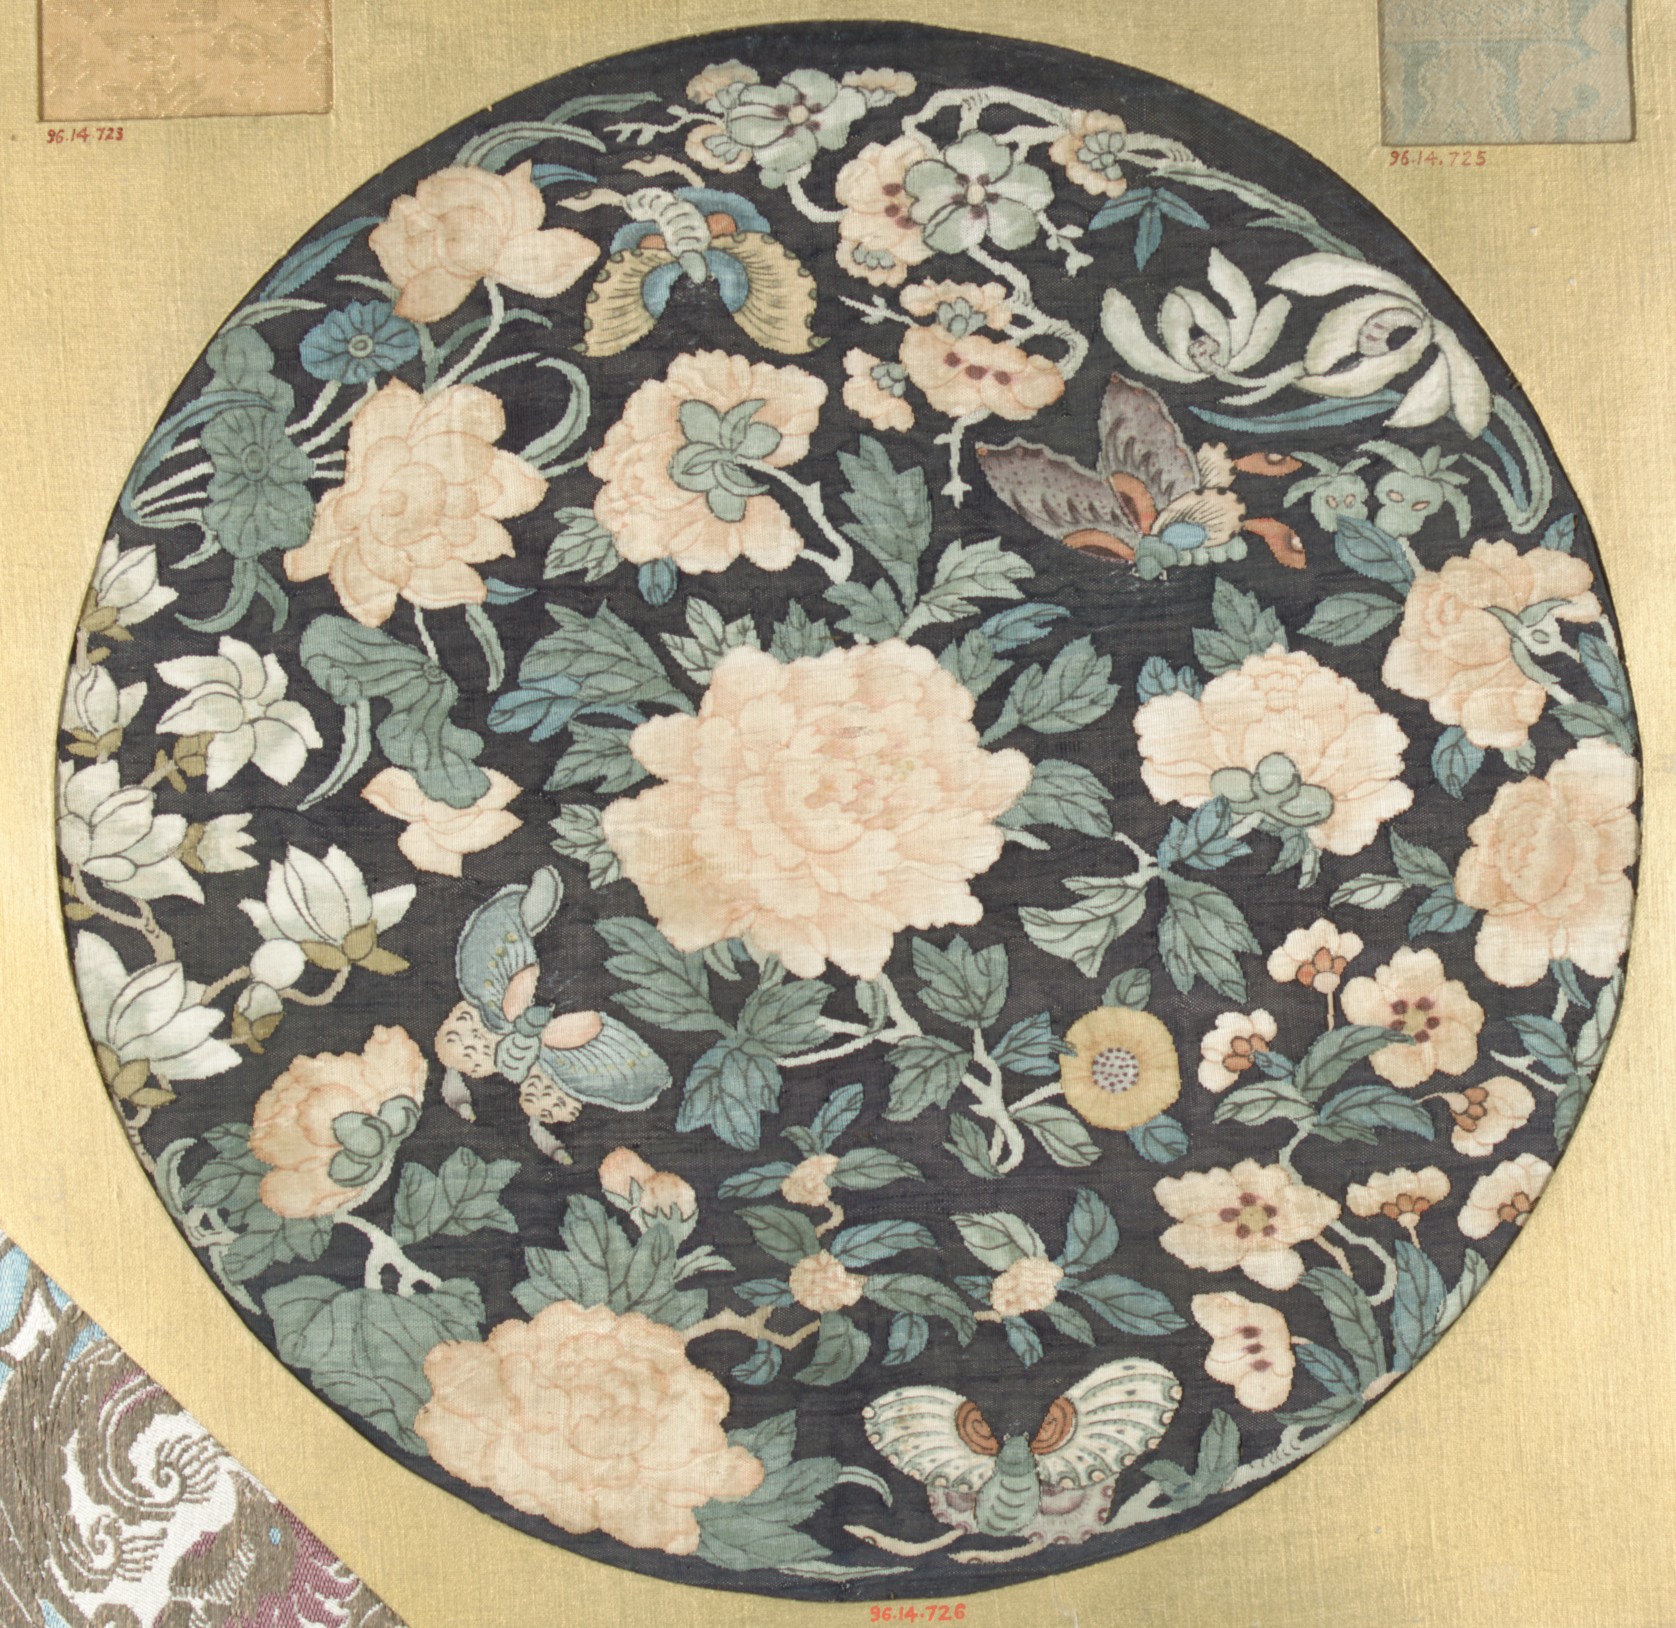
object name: medallion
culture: chinese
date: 1801-1900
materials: silk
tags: butterflies,leaves